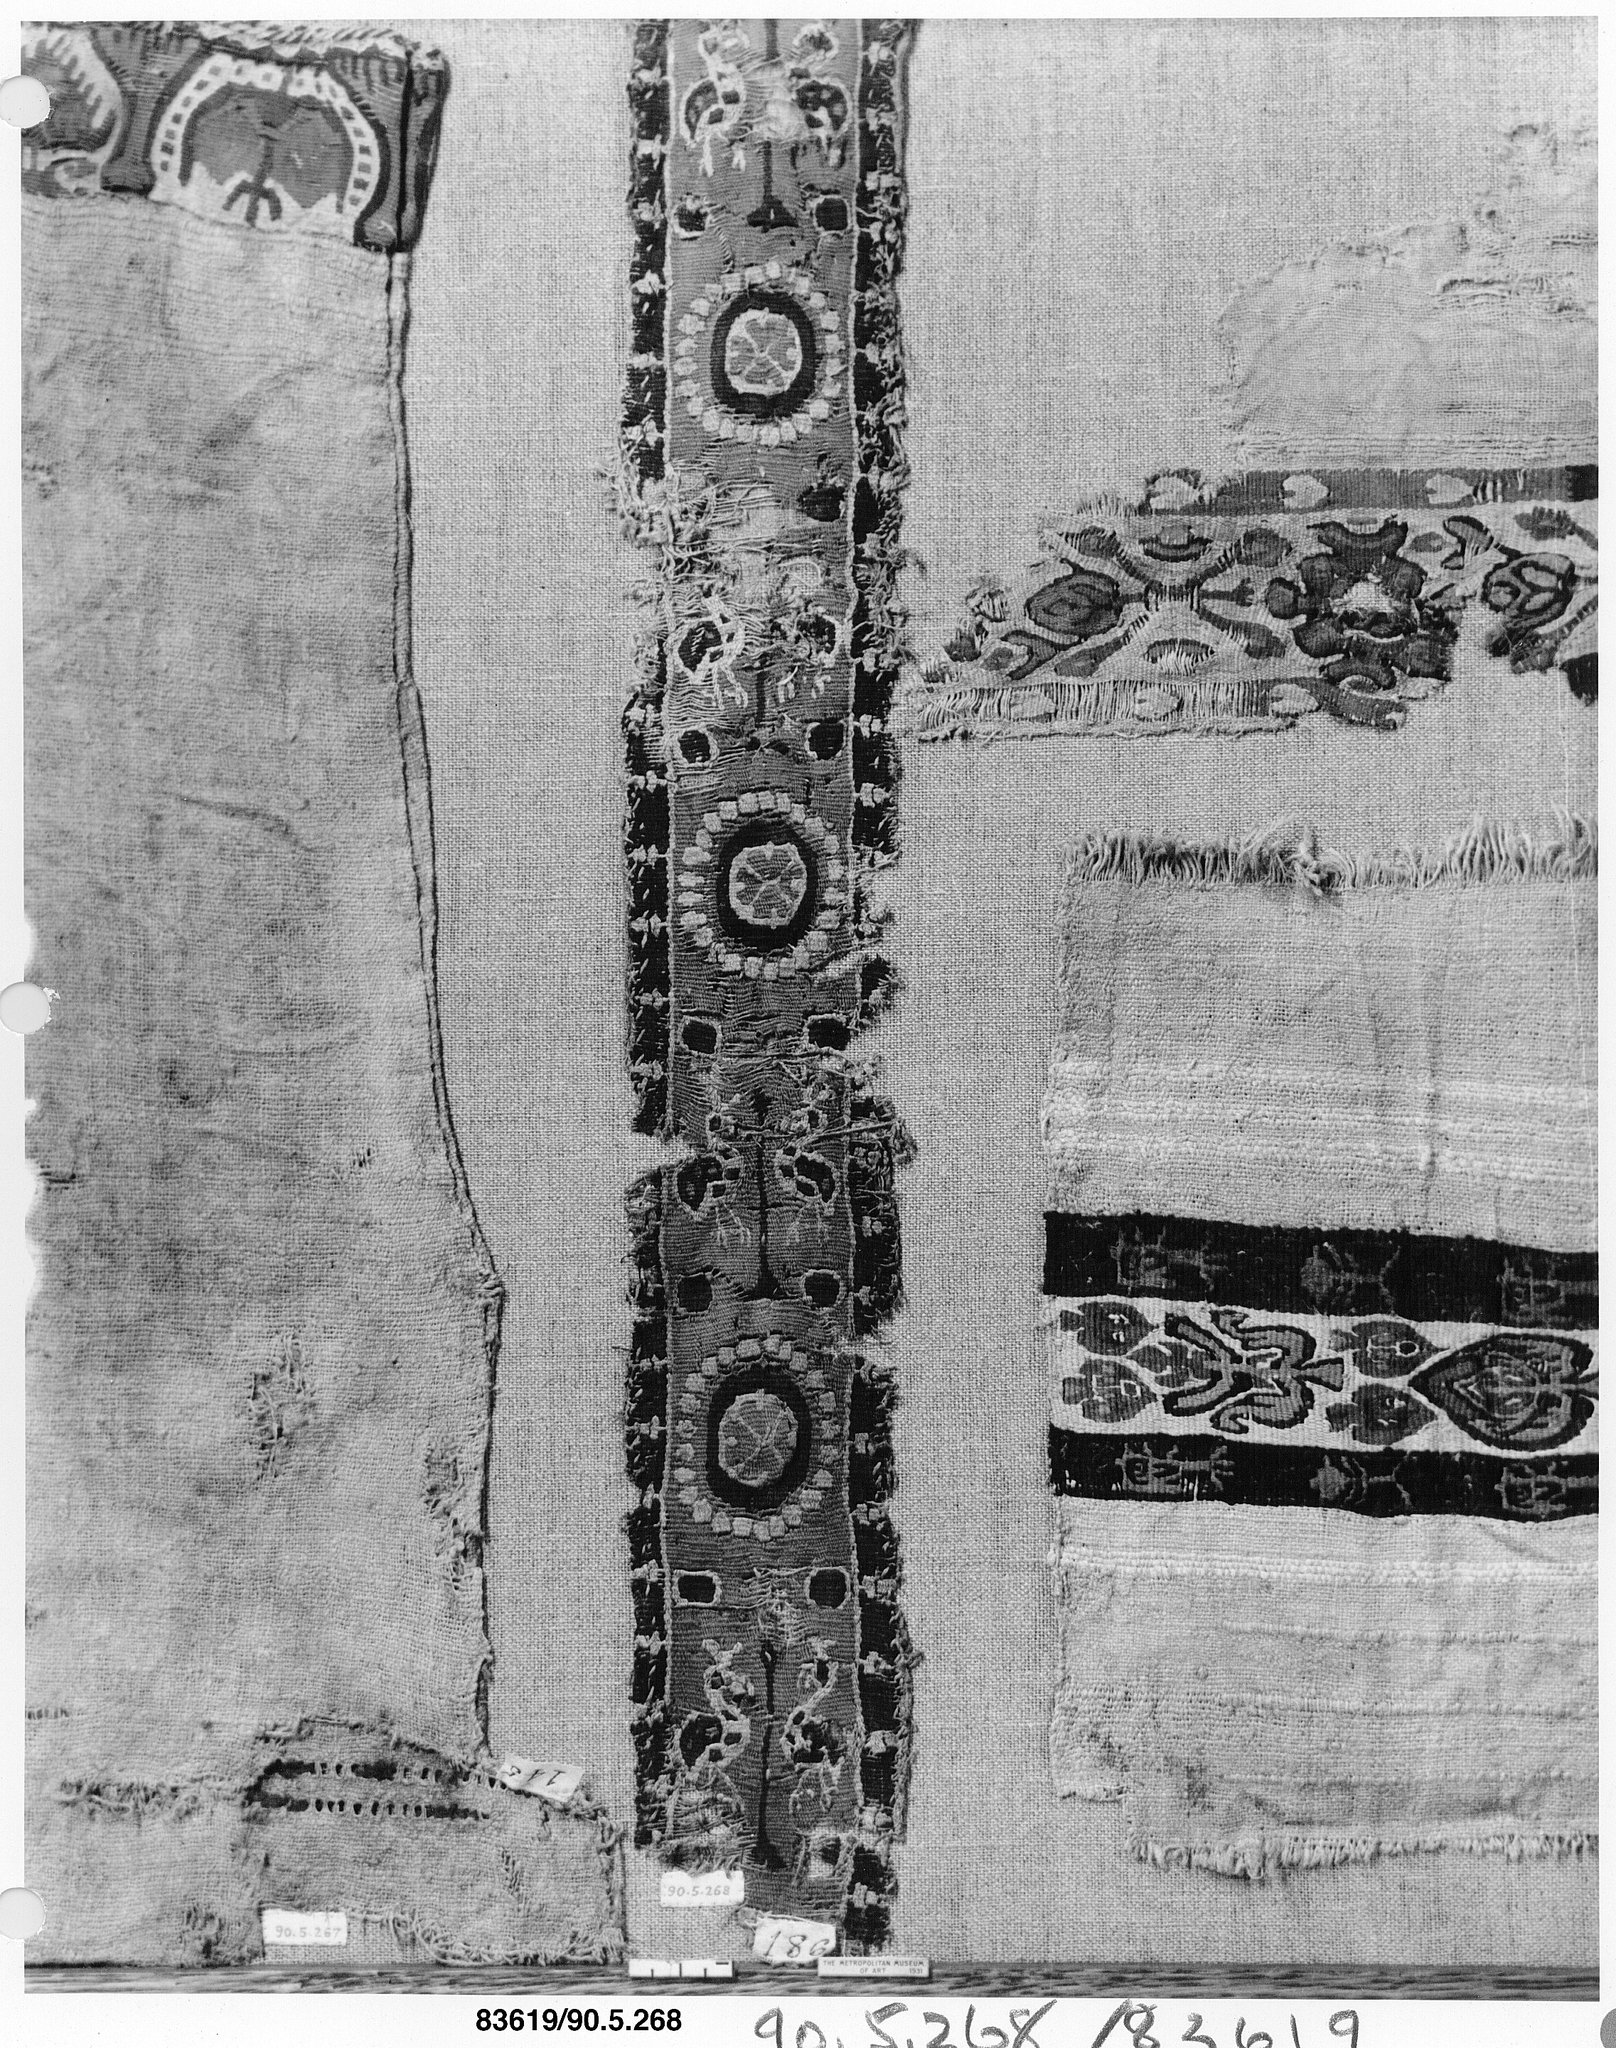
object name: textile fragment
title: Fragment of a Shoulder Band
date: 401-600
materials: linen, wool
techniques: weave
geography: egypt